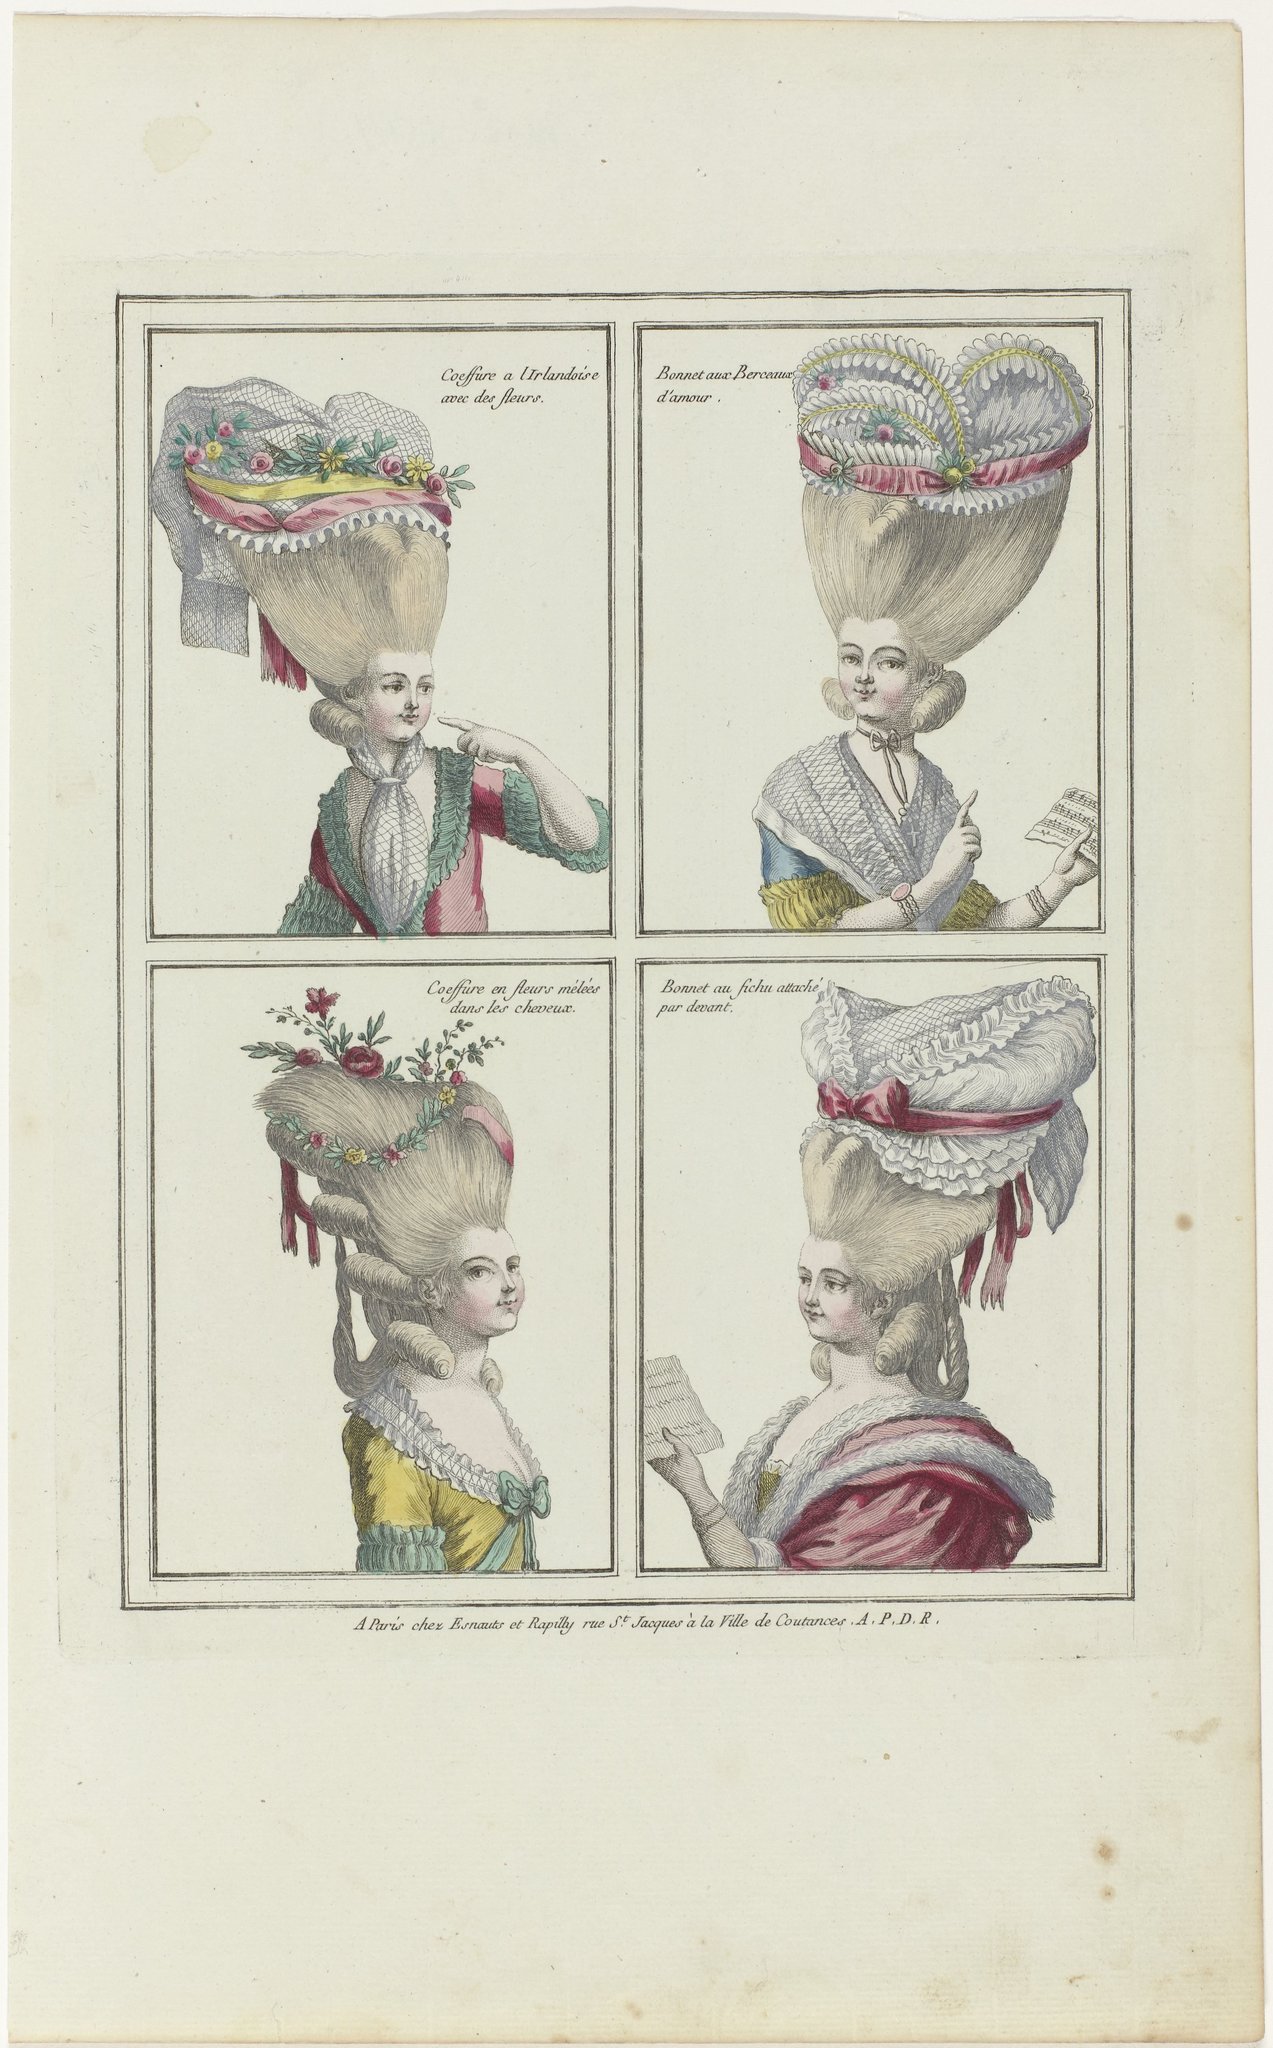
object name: fashion print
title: Gallerie des Modes et Costumes Francais, 1778, E 30 : Coeffure a l Irlandois (...)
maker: Anonymous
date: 1778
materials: paper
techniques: engraving, hand coloring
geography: paris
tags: clothing for the upper part of the body (+ women's clothes), head-gear (+ women's clothes), styles of hairdress - aa - ~ women, head-gear (bonnet) (+ women's clothes), fashion plates, printed edition of musical score, letter, envelope, piece of clothing covering the breast or décolleté (fichu) (+ women's clothes), bracelet, wristlet (+ women's clothes), necklace (+ women's clothes)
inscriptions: address: ‘A Paris chez Esnauts et Rapilly rue St. Jacques à la Ville de Coutances. A.P.D.R.’, inscription: ‘Coeffure a l' Irlandoise avec des fleurs / Bonnet aux Berceaux d'amour. / Coeffure en fleurs mélées dans les cheveux. / Bonnet au fichu attaché par devant.’